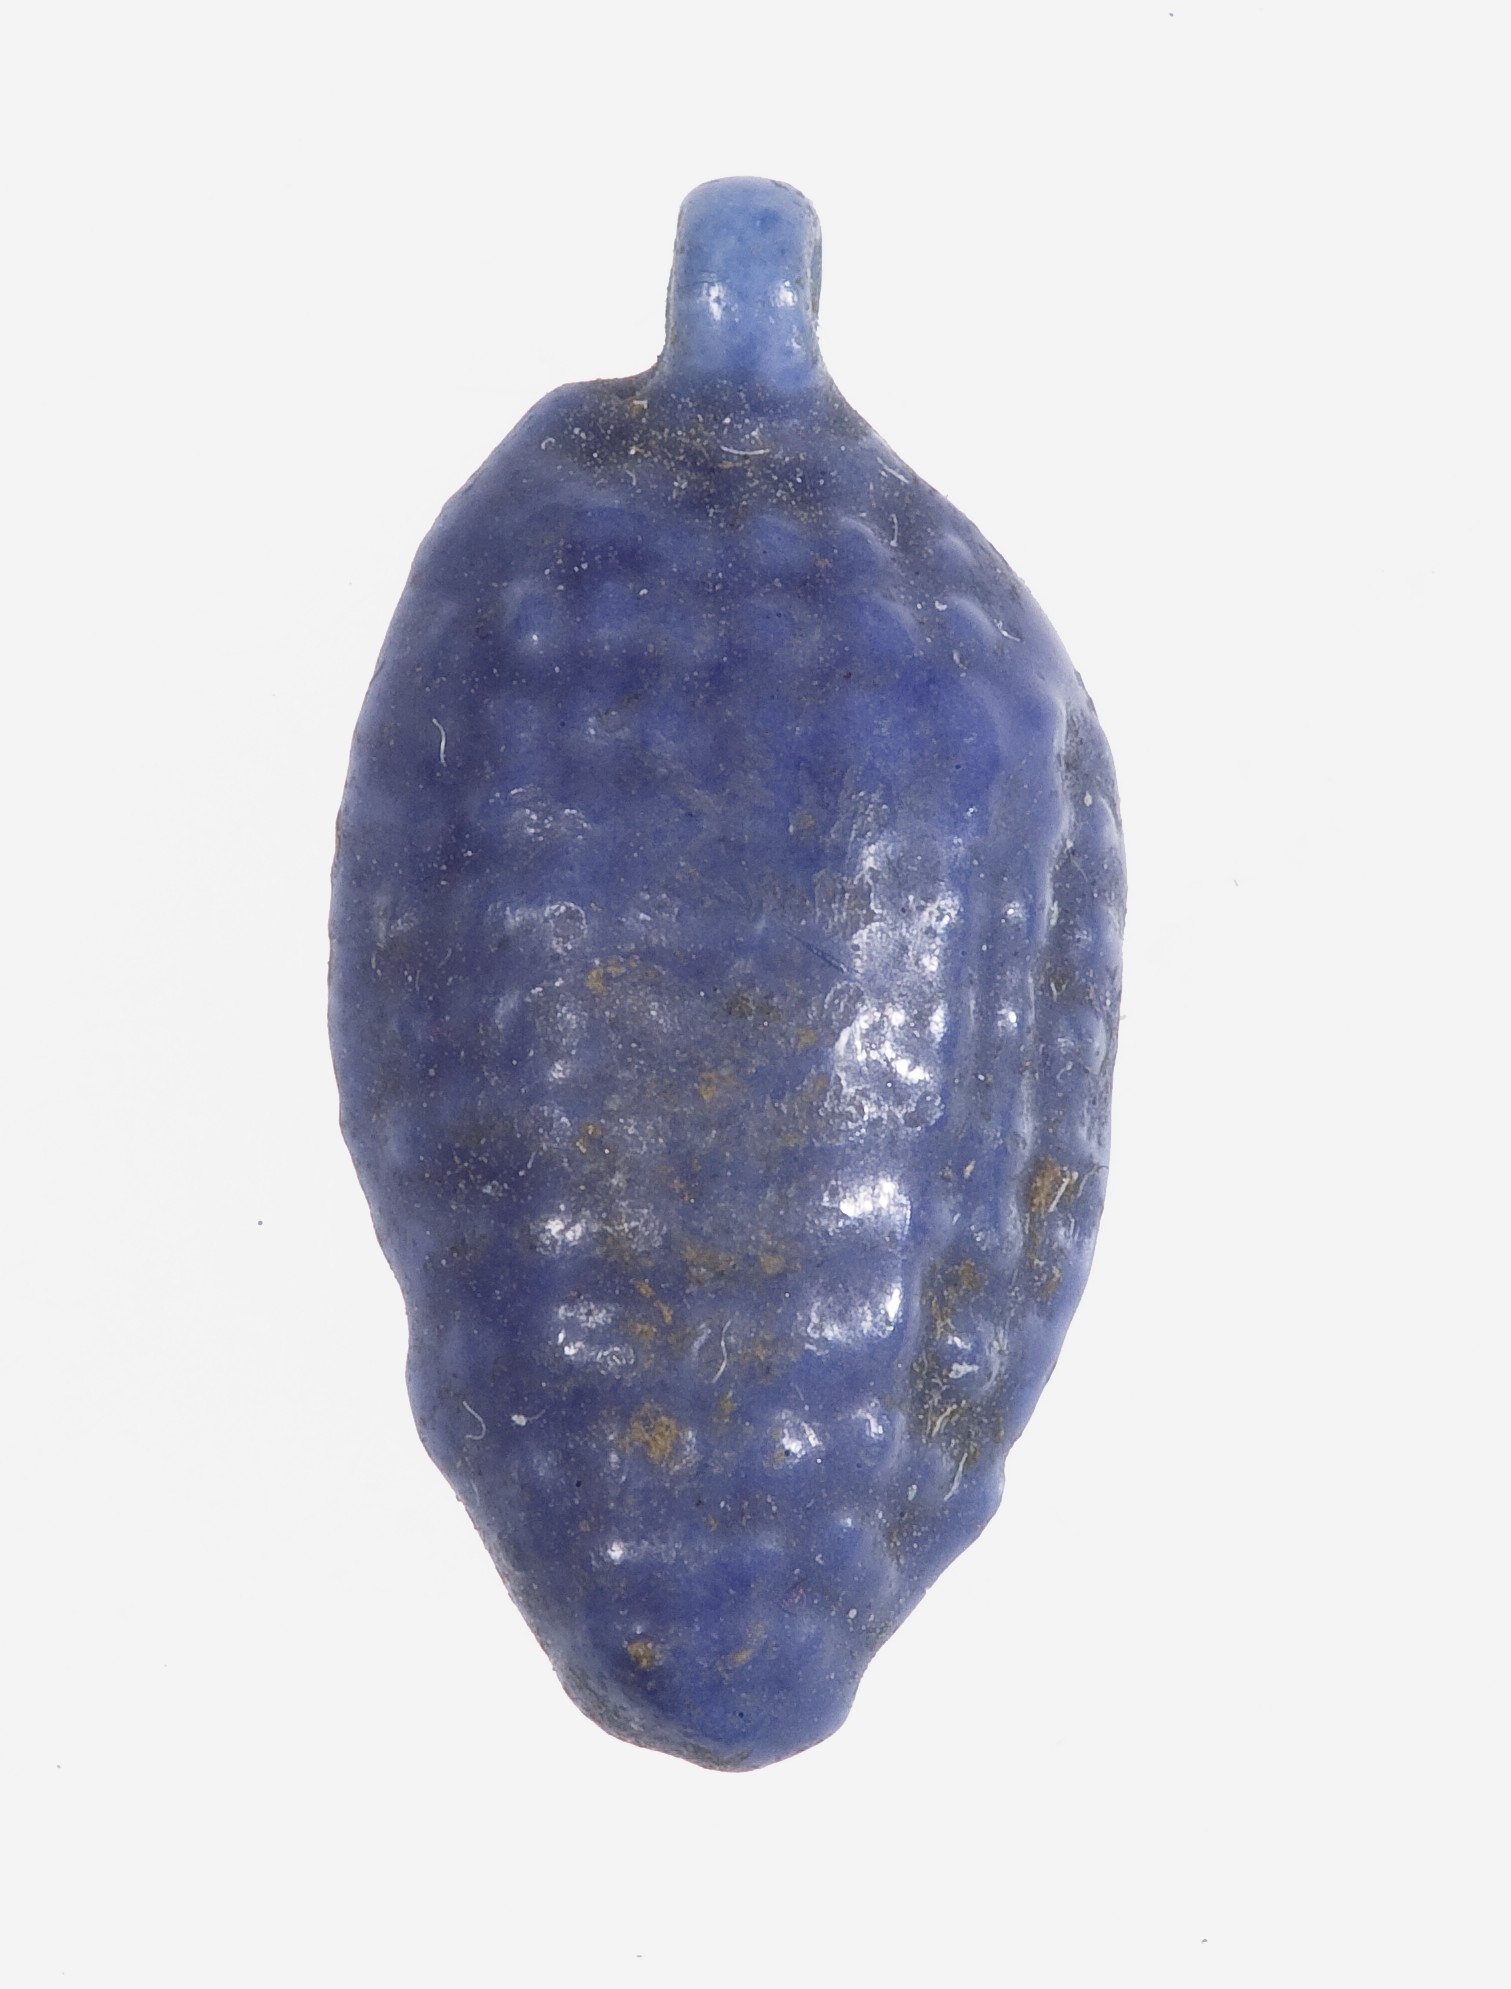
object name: pendant, grape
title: Pendant: Bunch of Grapes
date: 1390-1352 BCE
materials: faience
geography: egypt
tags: grapes